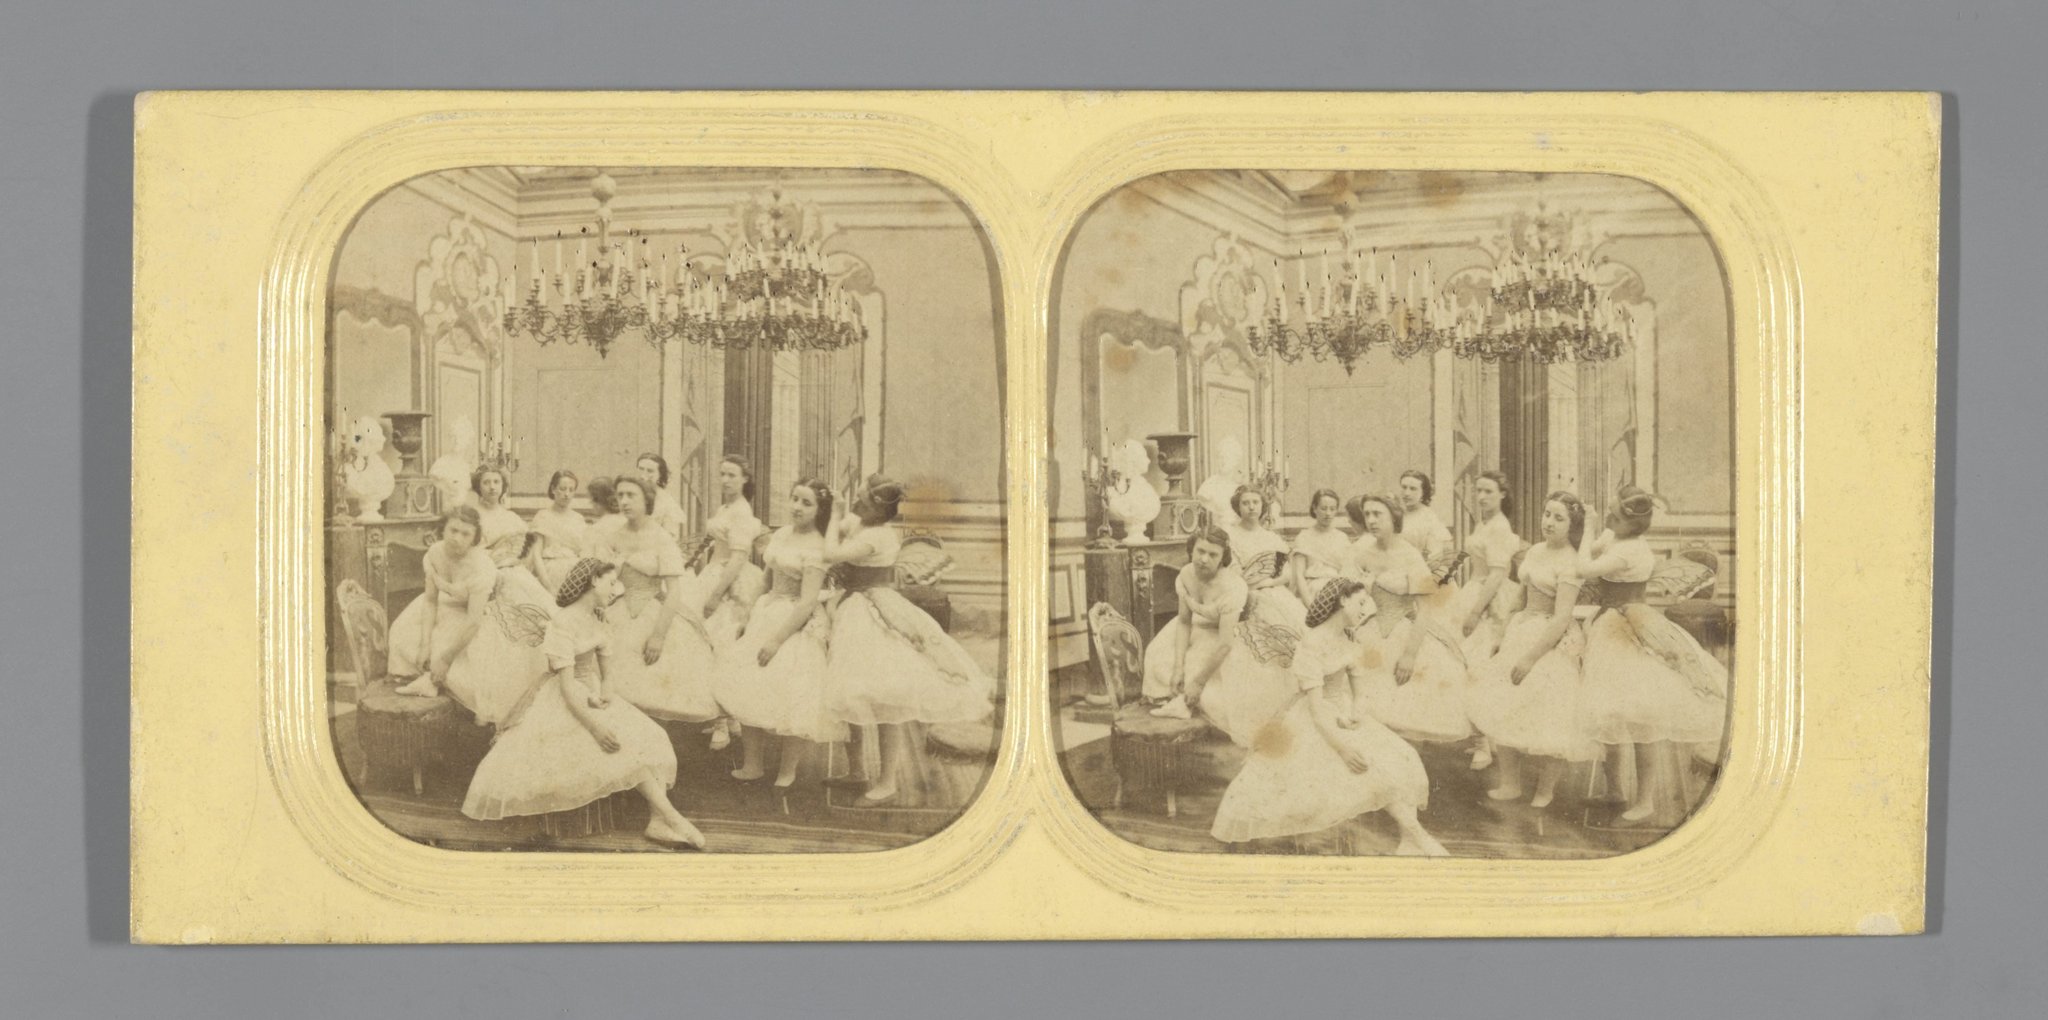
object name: tissue stereograph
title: Balletdansers voor een optreden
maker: Anonymous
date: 1855-1875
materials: cardboard, paper, photographic support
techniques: albumen print, cutting, hand coloring, perforating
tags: the ballet, ballet performance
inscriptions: inscription: ‘90 ct’